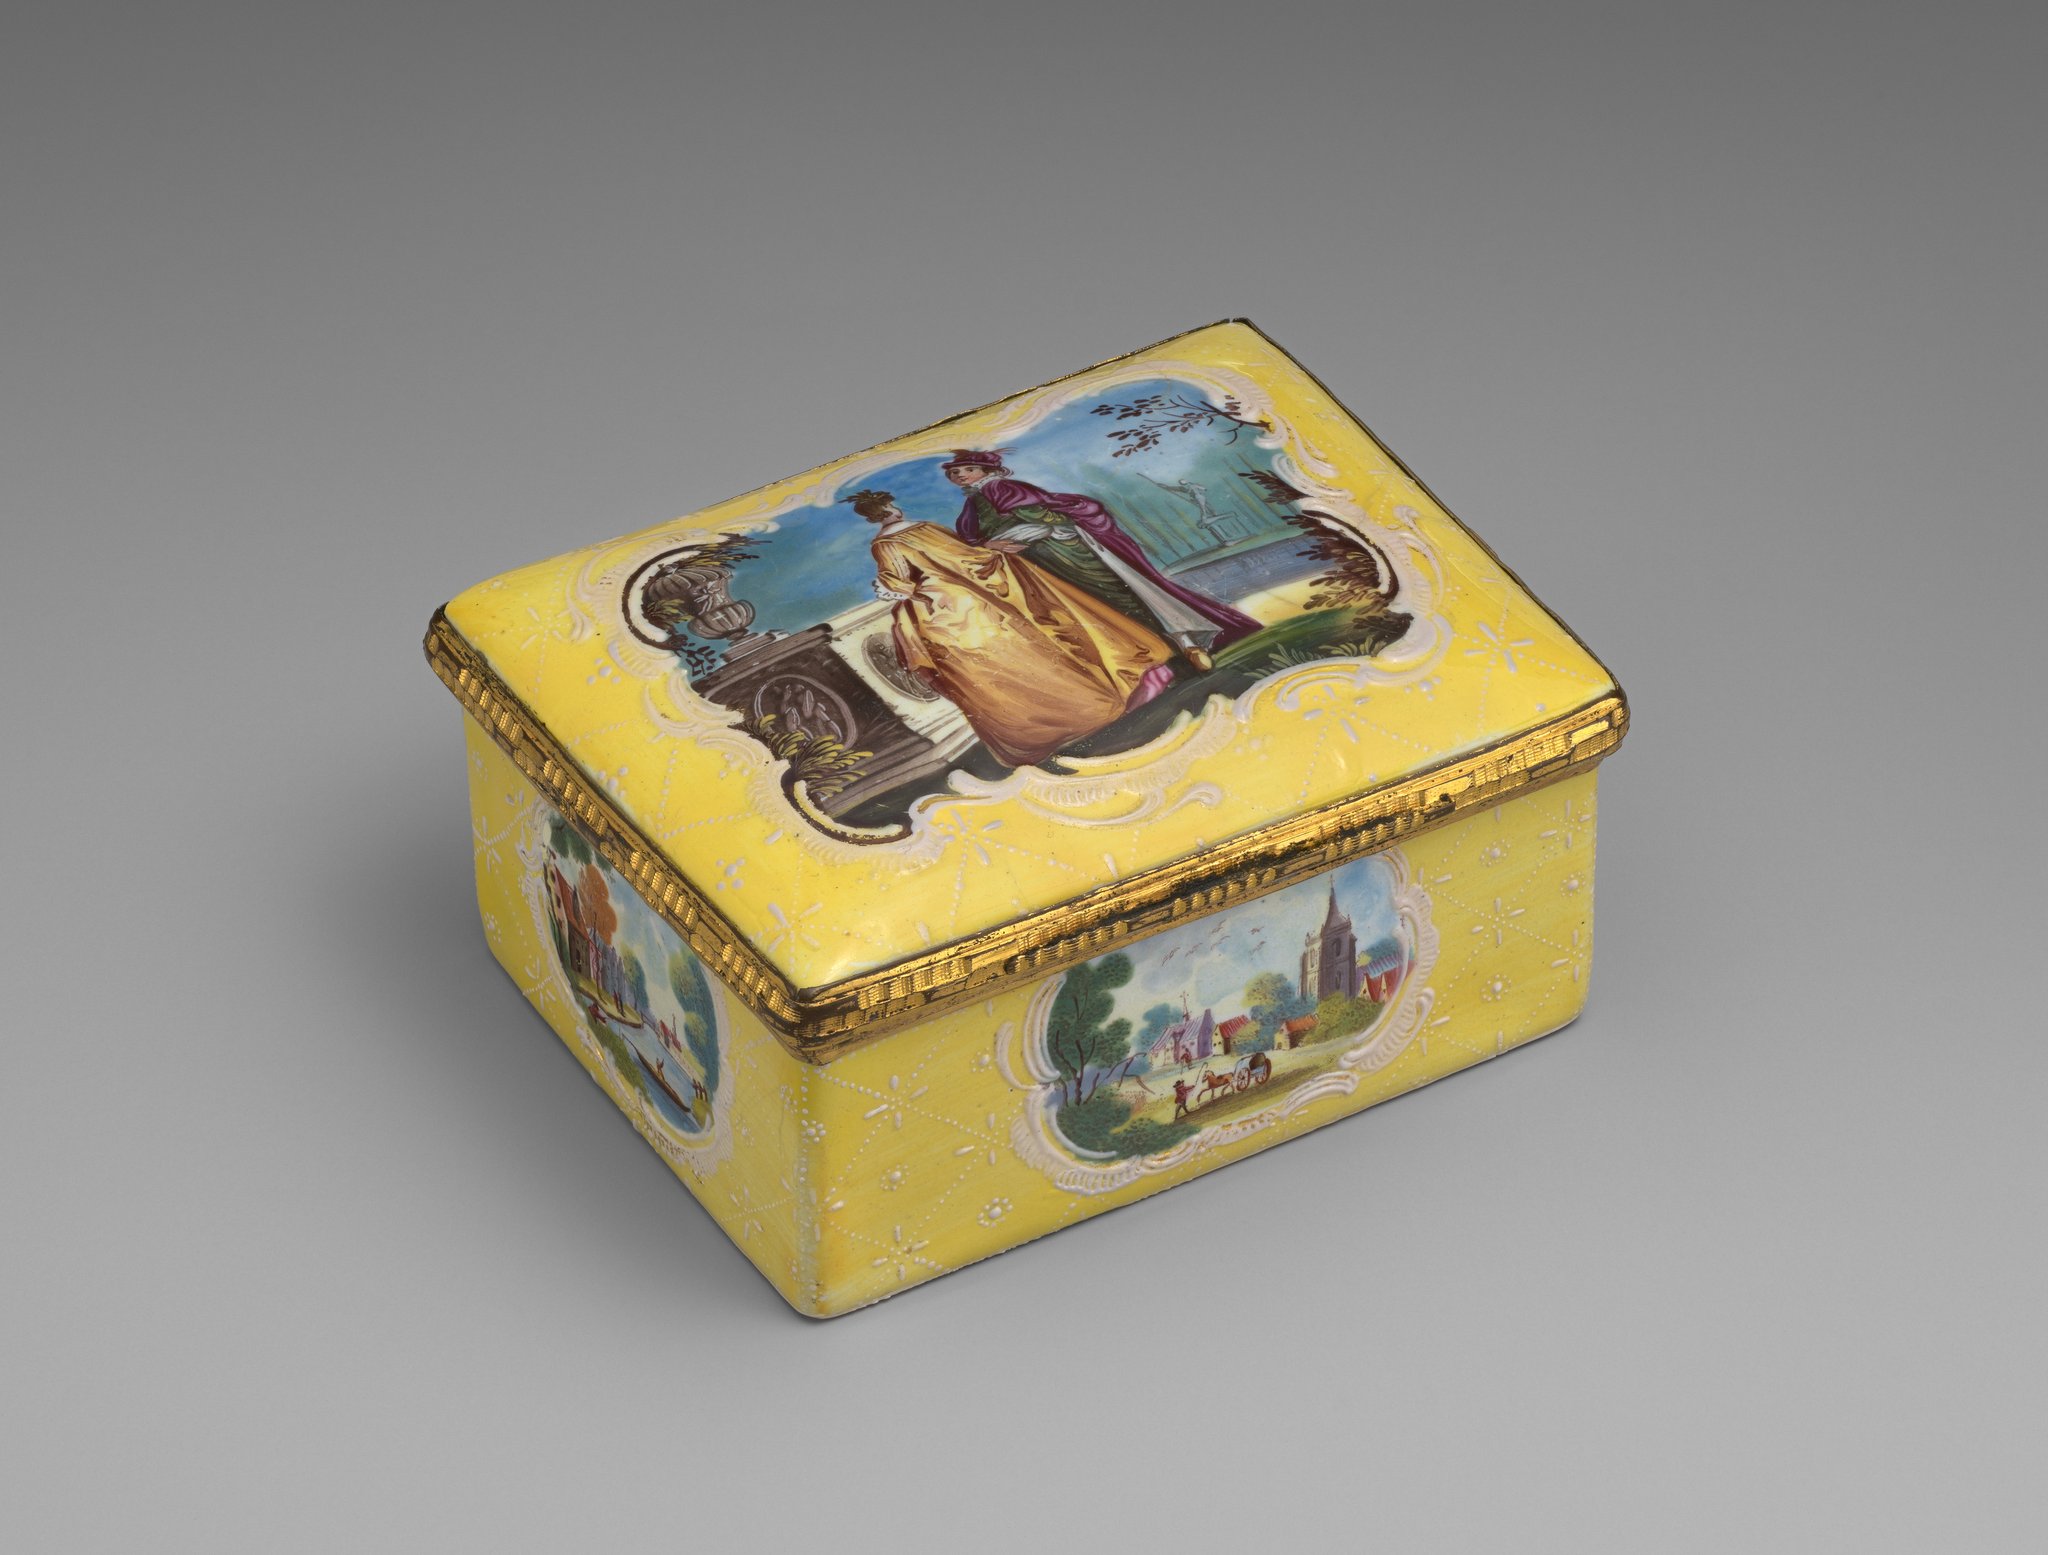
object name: snuffbox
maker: charles nicolas cochin ii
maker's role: engraver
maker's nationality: french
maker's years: 1715-1790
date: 1765-1770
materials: copper, enamel